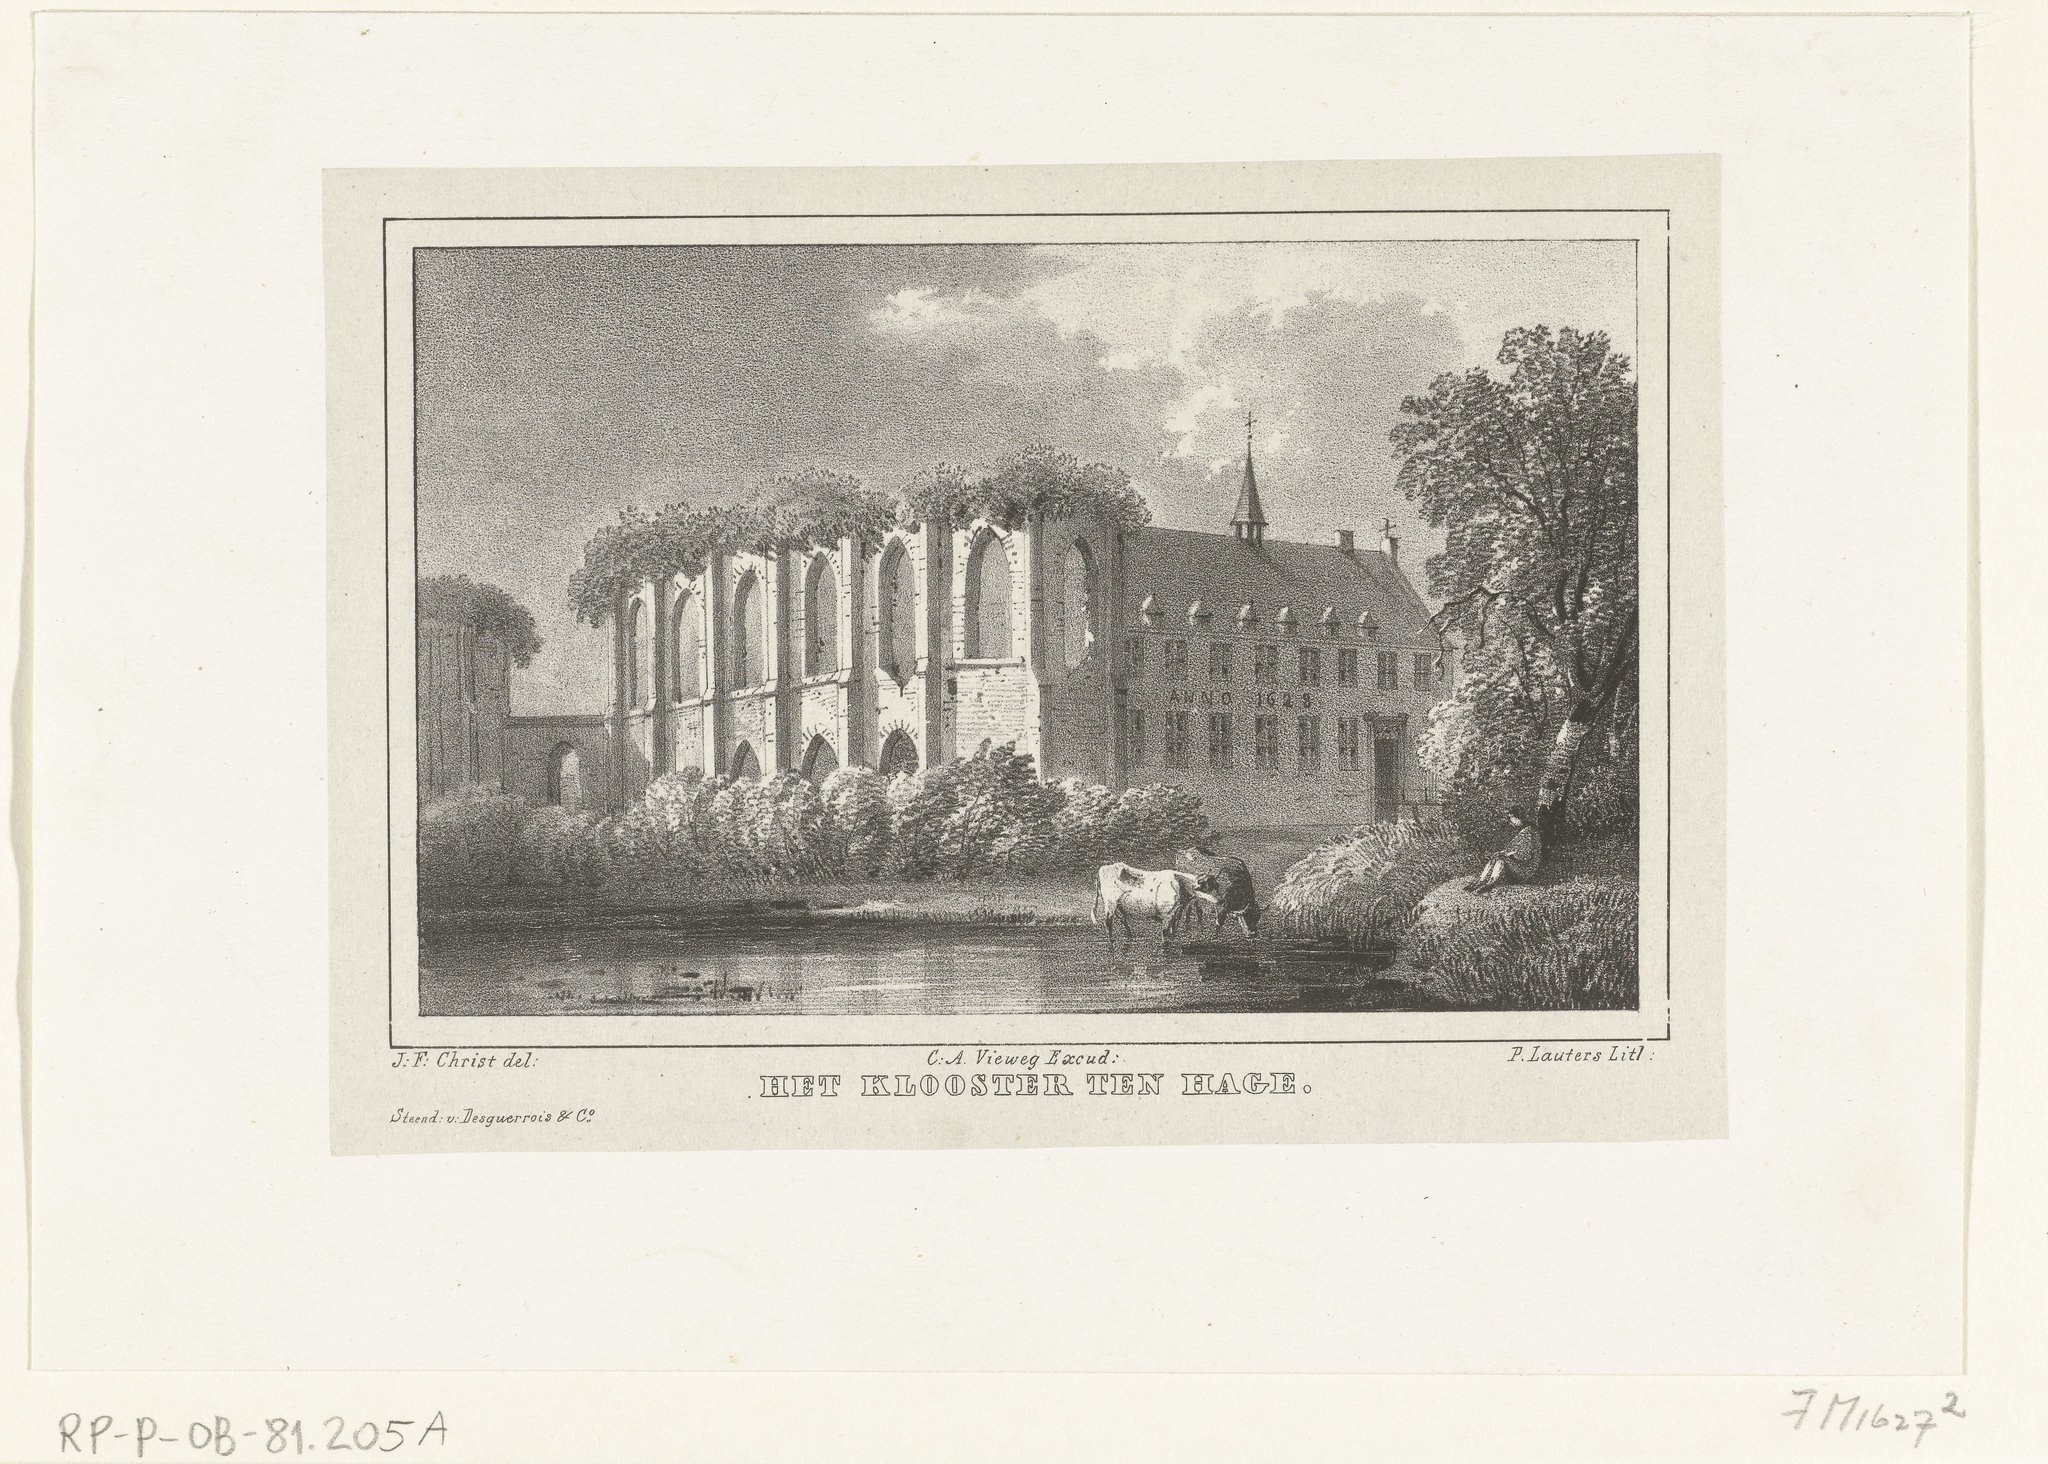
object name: print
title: Klooster Ten Hage, gebruikt ter inlegering tijdens het beleg van Den Bosch, 1629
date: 1837-1846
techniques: printmaking, lithograph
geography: netherlands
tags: frederick henry (prince of orange), cloisters ~ monastery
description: Gebruikt als illustratie in: C.P.E. Robidé van der Aa, Oud-Nederland in de uit vroegere dagen, overgeblevene burgen en kasteelen, geschetst en afgebeeld, Vieweg, Nijmegen 1841-1846.